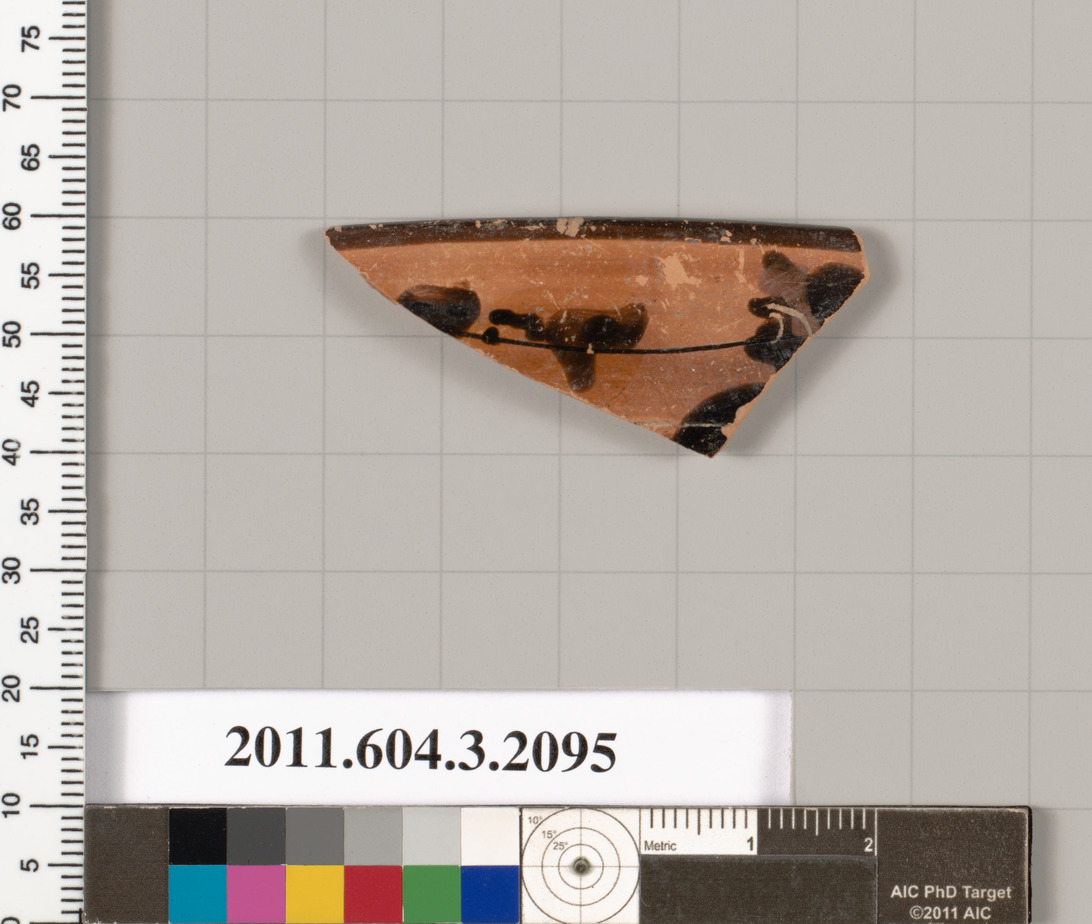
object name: kylix fragment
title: Terracotta rim fragment of a kylix (drinking cup)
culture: greek, attic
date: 534-468 BCE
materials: terracotta